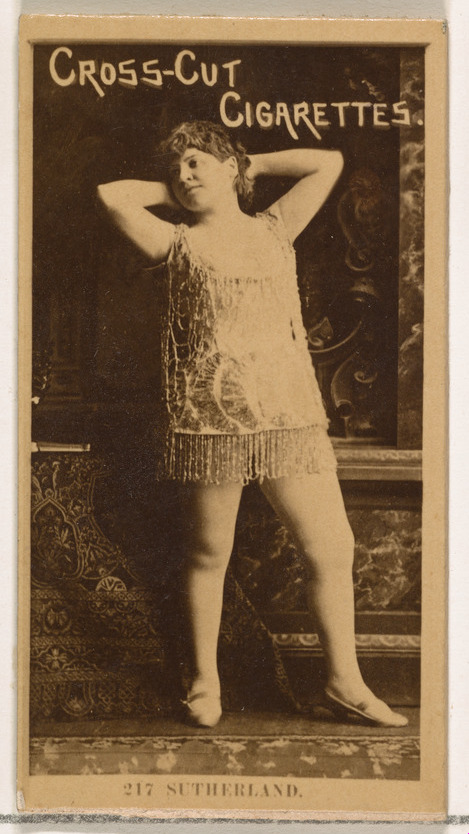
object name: print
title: Card Number 217, Sutherland, from the Actors and Actresses series (N145-2) issued by Duke Sons & Co. to promote Cross Cut Cigarettes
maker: w. duke, sons & co.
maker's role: publisher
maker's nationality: american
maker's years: 1870-1920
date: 1880-1889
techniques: albumen silver print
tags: portraits,women,actresses